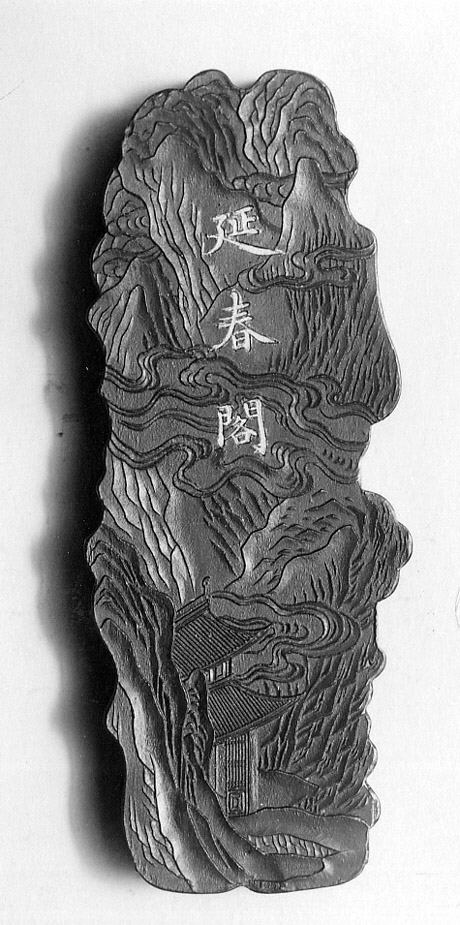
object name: ink tablet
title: Pavilion for Prolonging Spring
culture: chinese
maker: jian guzhai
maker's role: artist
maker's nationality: chinese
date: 1867-1933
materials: gilt, wood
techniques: bookbinding